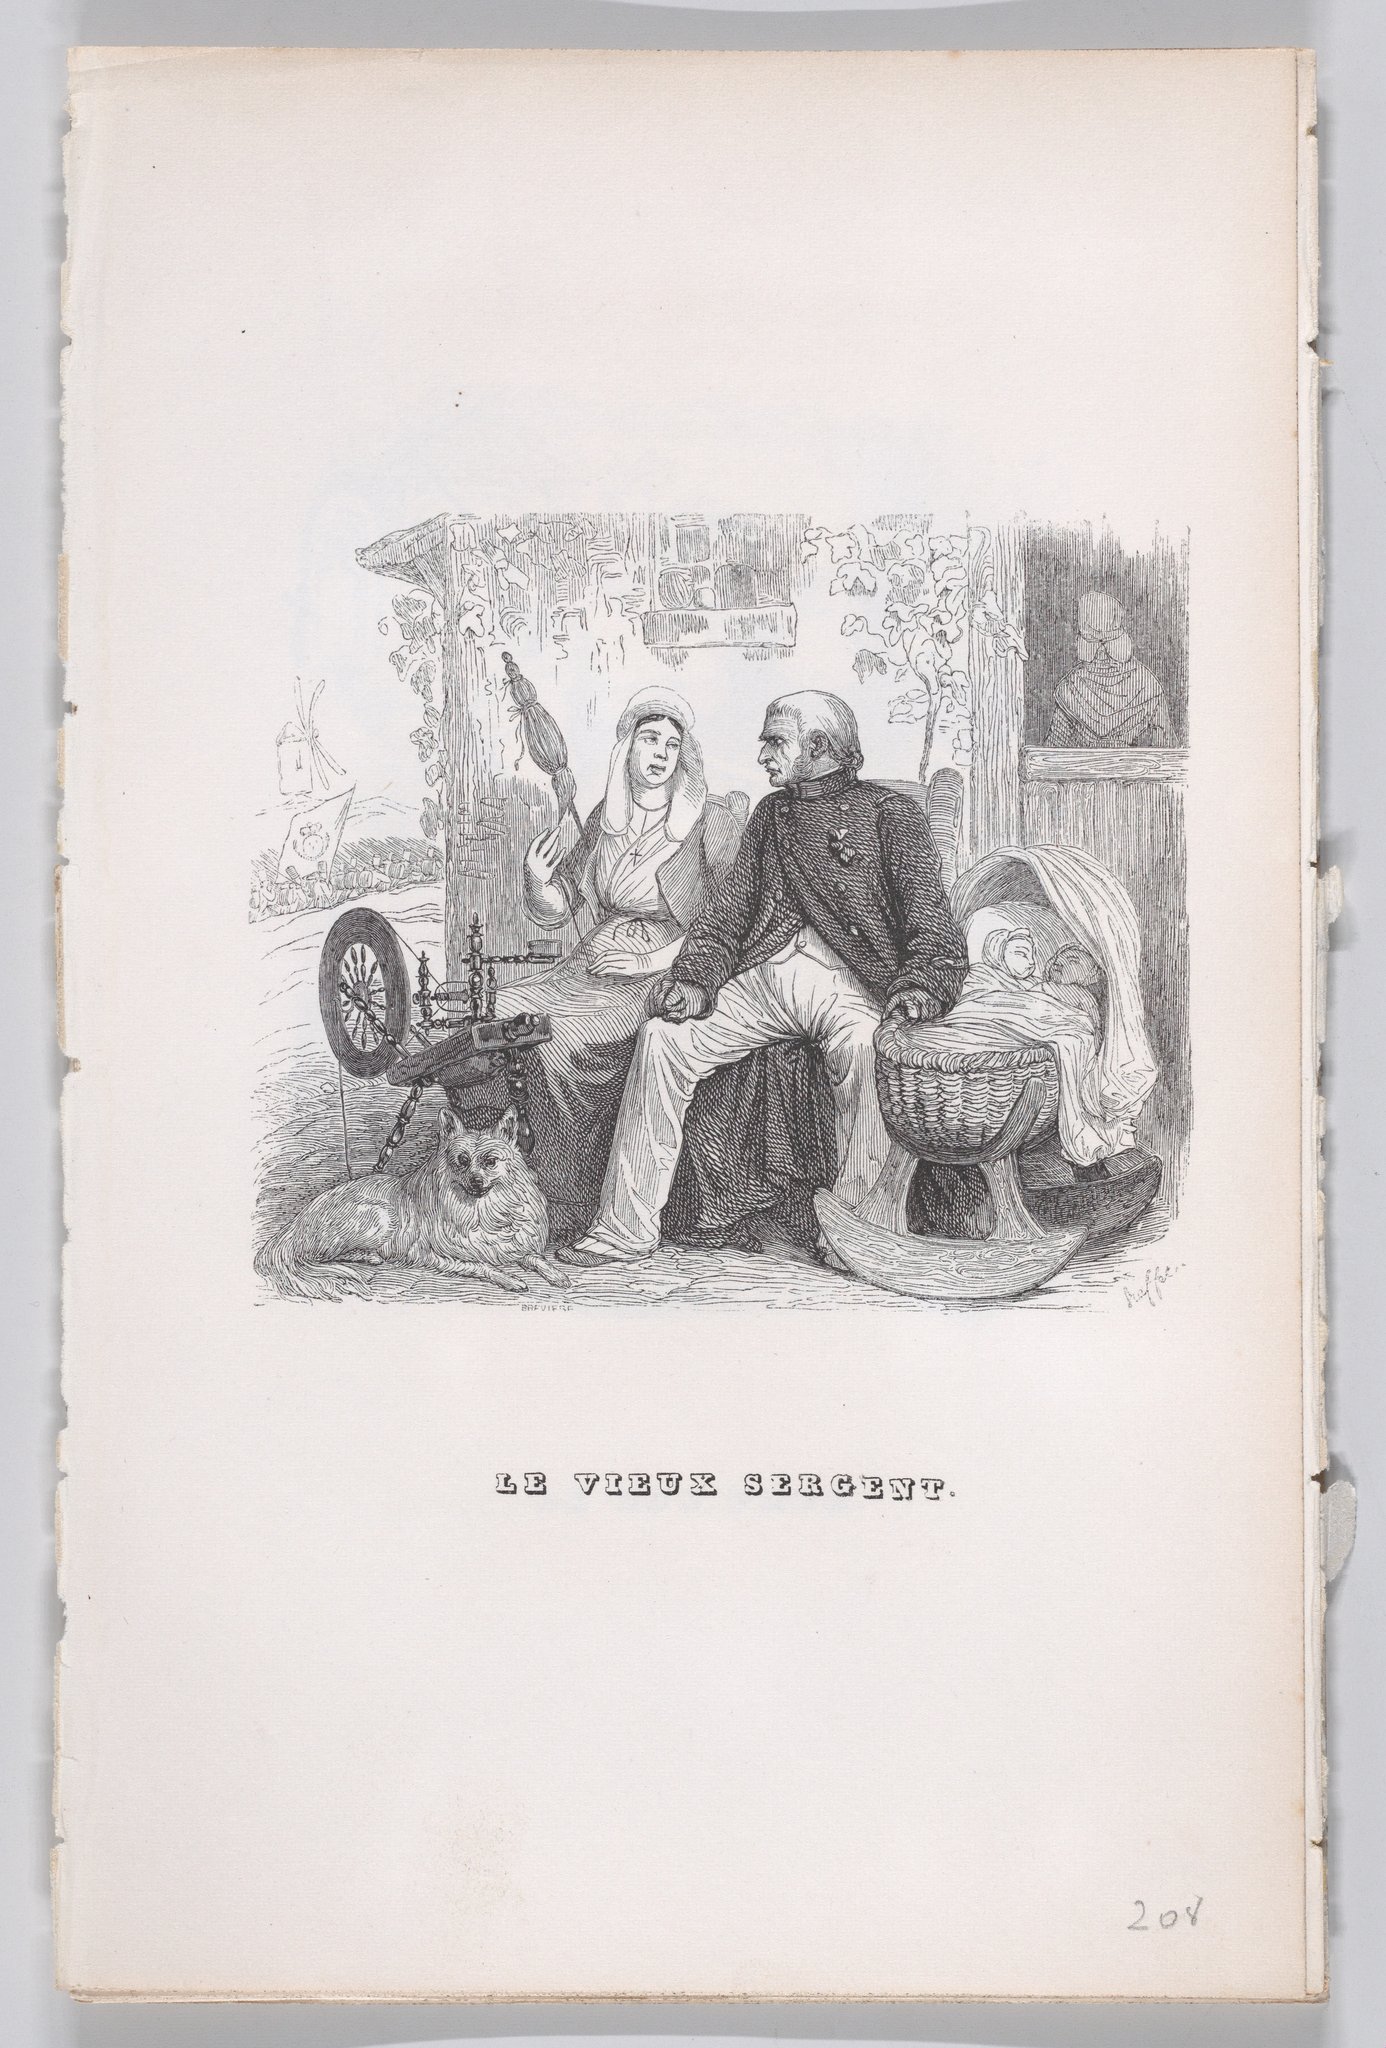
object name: print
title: The Old Sergeant, from "The Complete Works of Béranger"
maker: j. j. grandville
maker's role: illustrator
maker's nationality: french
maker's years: 1803-1847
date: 1836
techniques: engraving